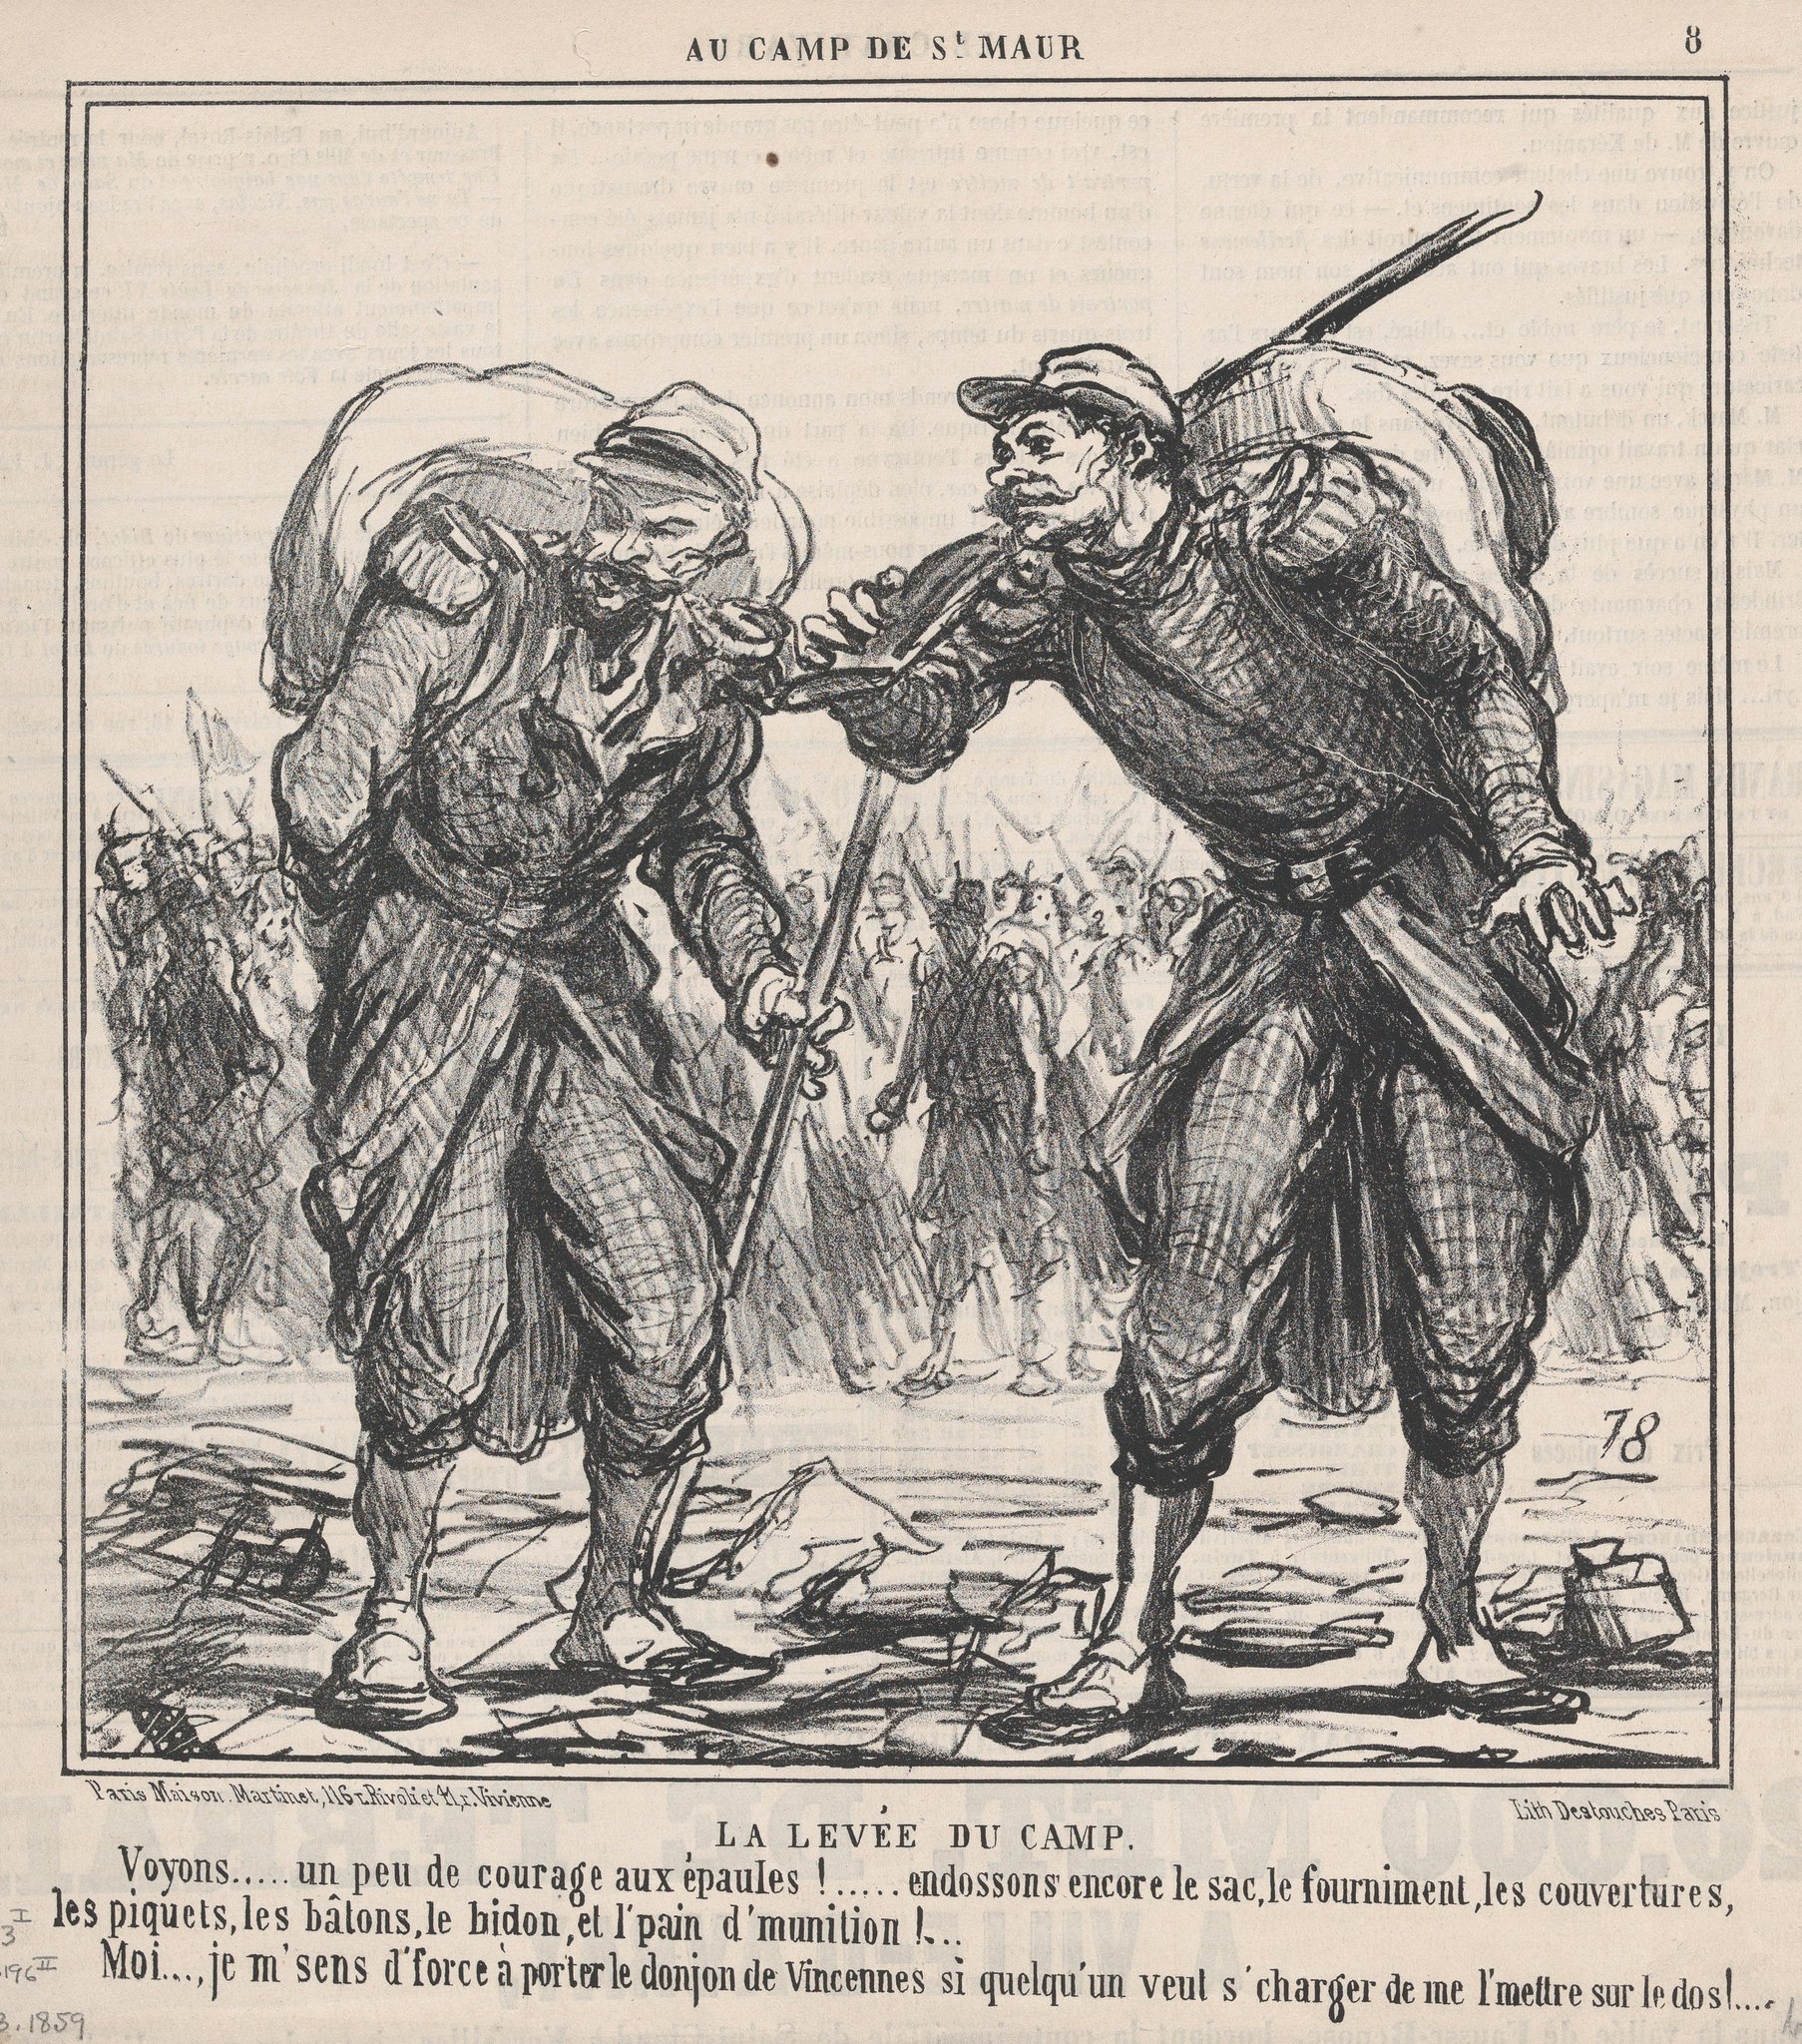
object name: print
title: La Levée du Camp, from "Au Camp de Saint-Maur"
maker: honoré daumier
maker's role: artist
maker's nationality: french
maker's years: 1808-1879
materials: paper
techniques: lithograph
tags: men